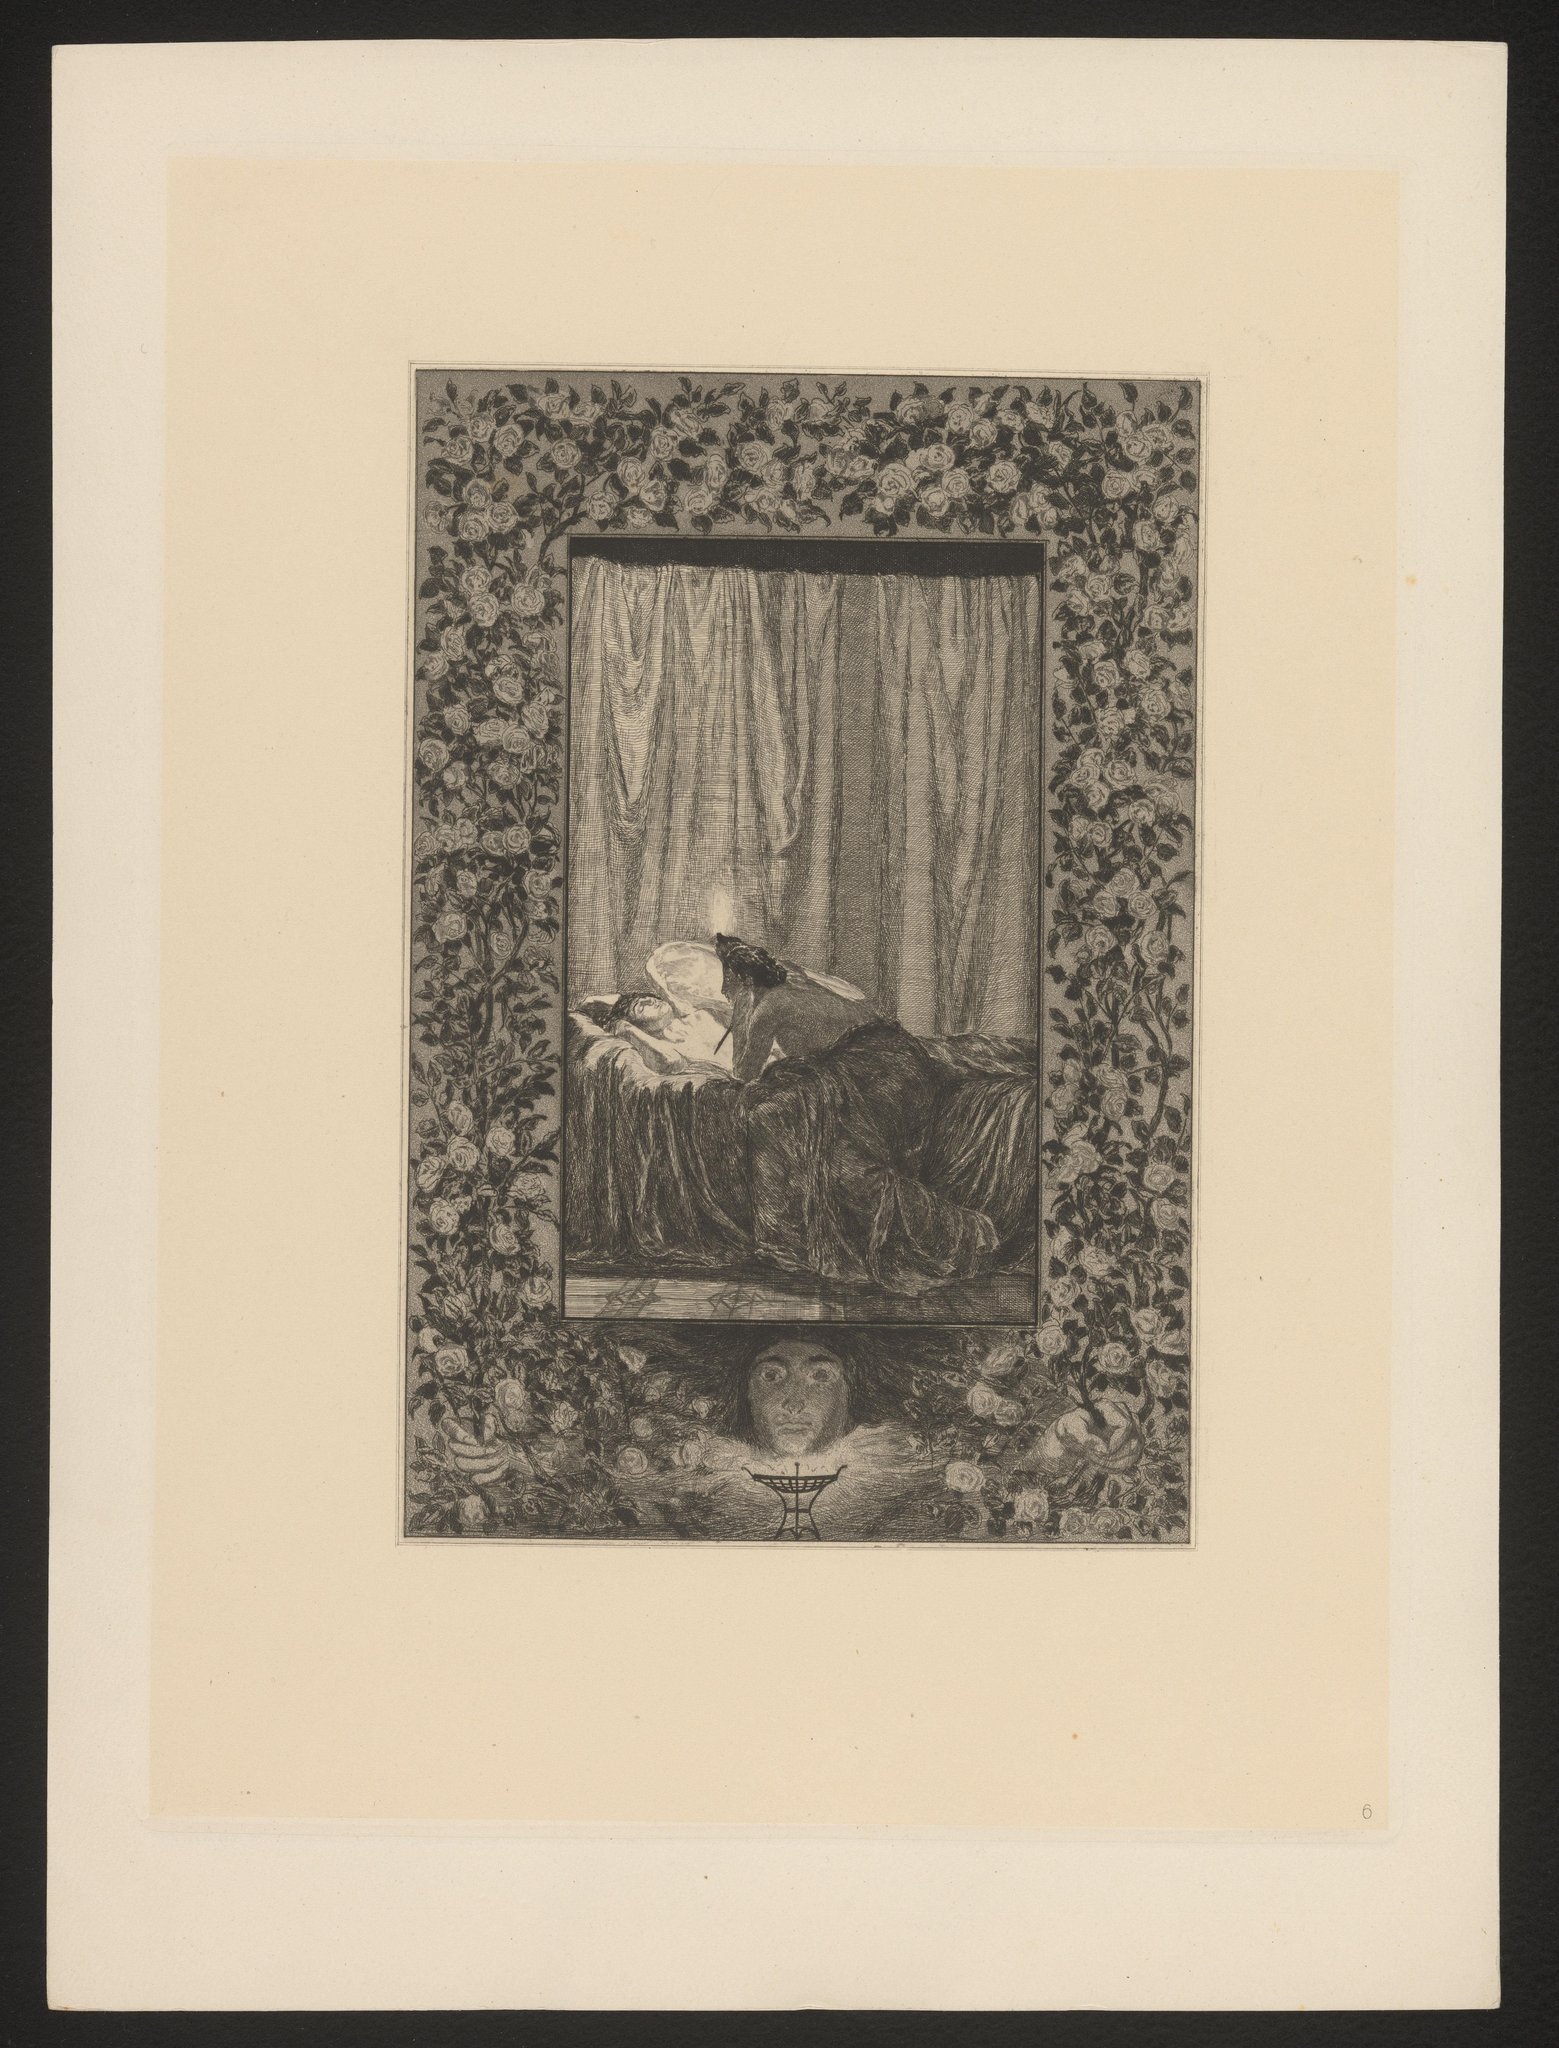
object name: print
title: Psyche mit der Lampe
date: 1880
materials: paper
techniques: aquatint, etching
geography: nuremberg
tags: other scenes from the story of cupid and psyche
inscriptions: collector's mark: Lugt 2228